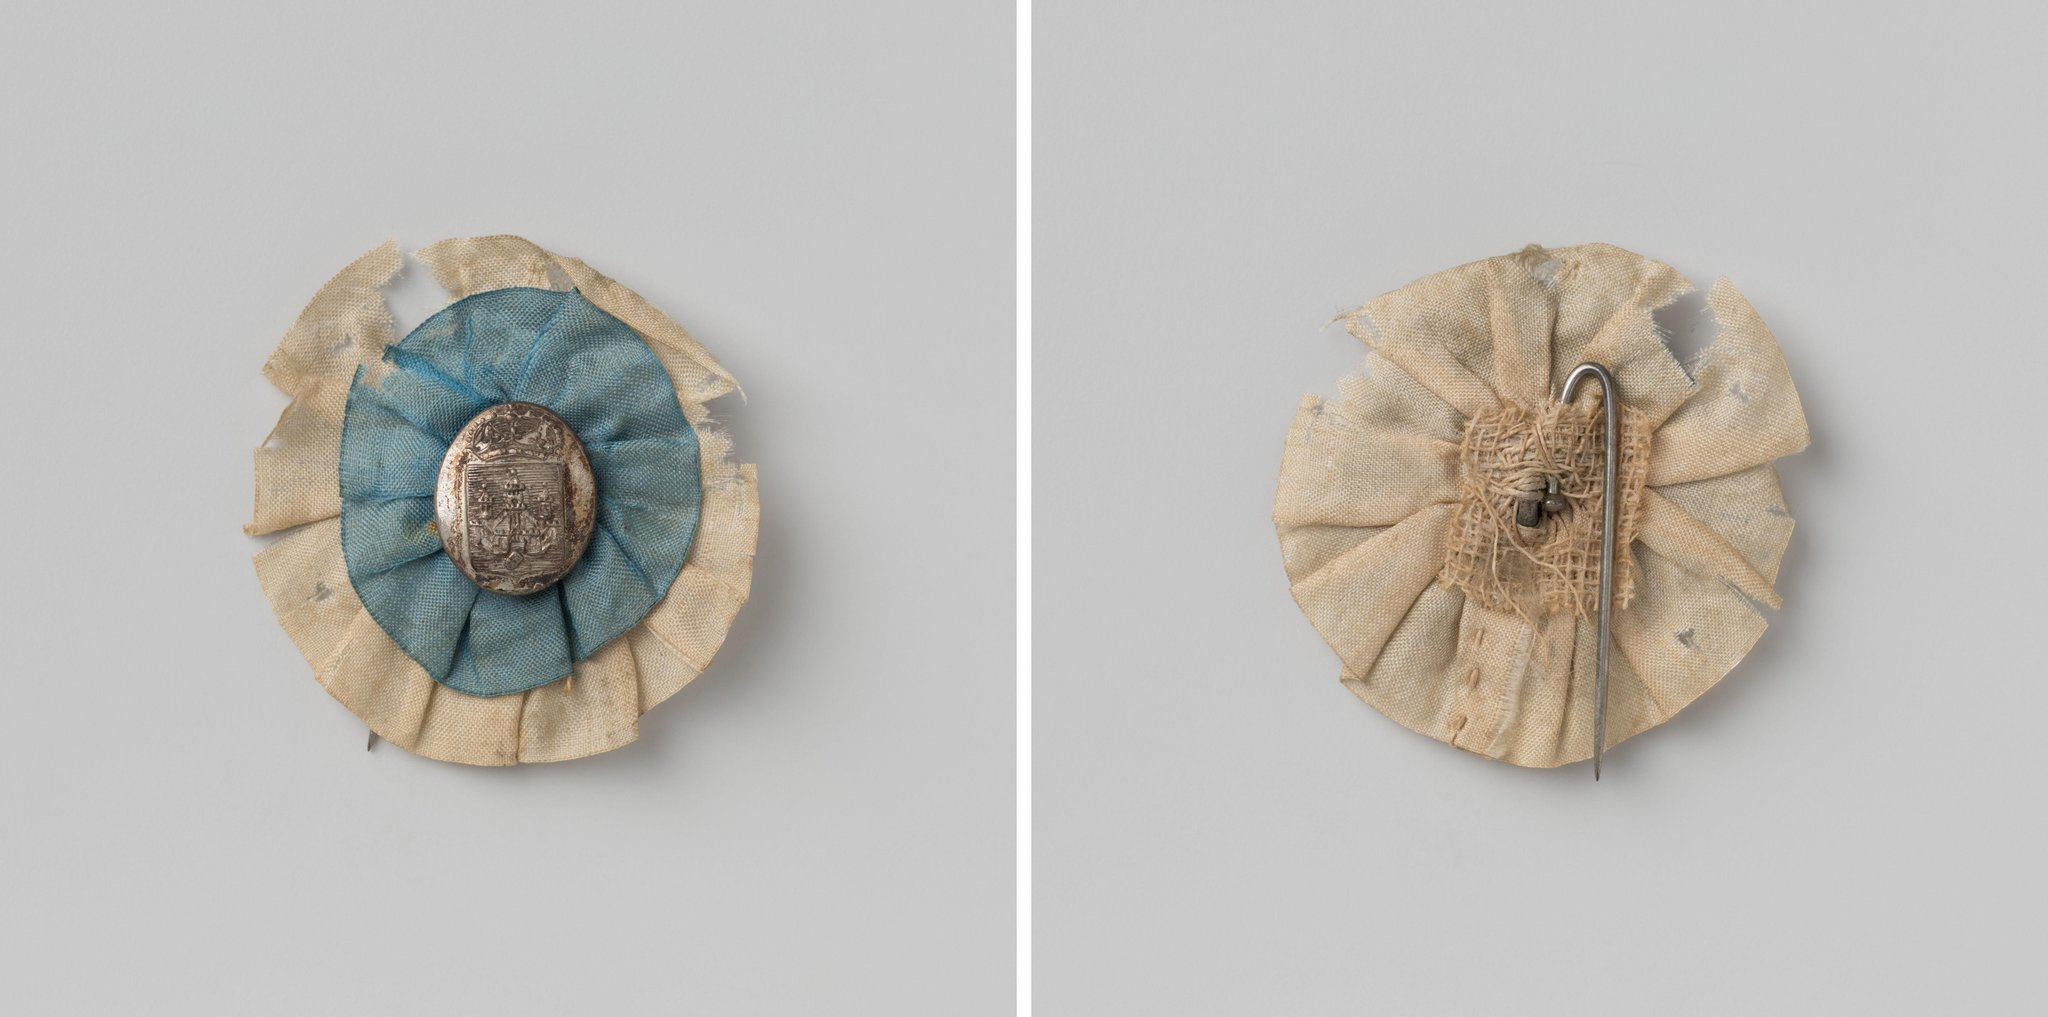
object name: insignia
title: Stad Antwerpen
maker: Anonymous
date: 1800-1875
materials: textile, tin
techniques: striking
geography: antwerp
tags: antwerp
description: Eenzijdig insigne, bestaande uit ovaal schildje met gekroond wapenschild, gemonteerd op twee rozetten van geplooid blauw en wit textiel. Keerzijde draagspeld.